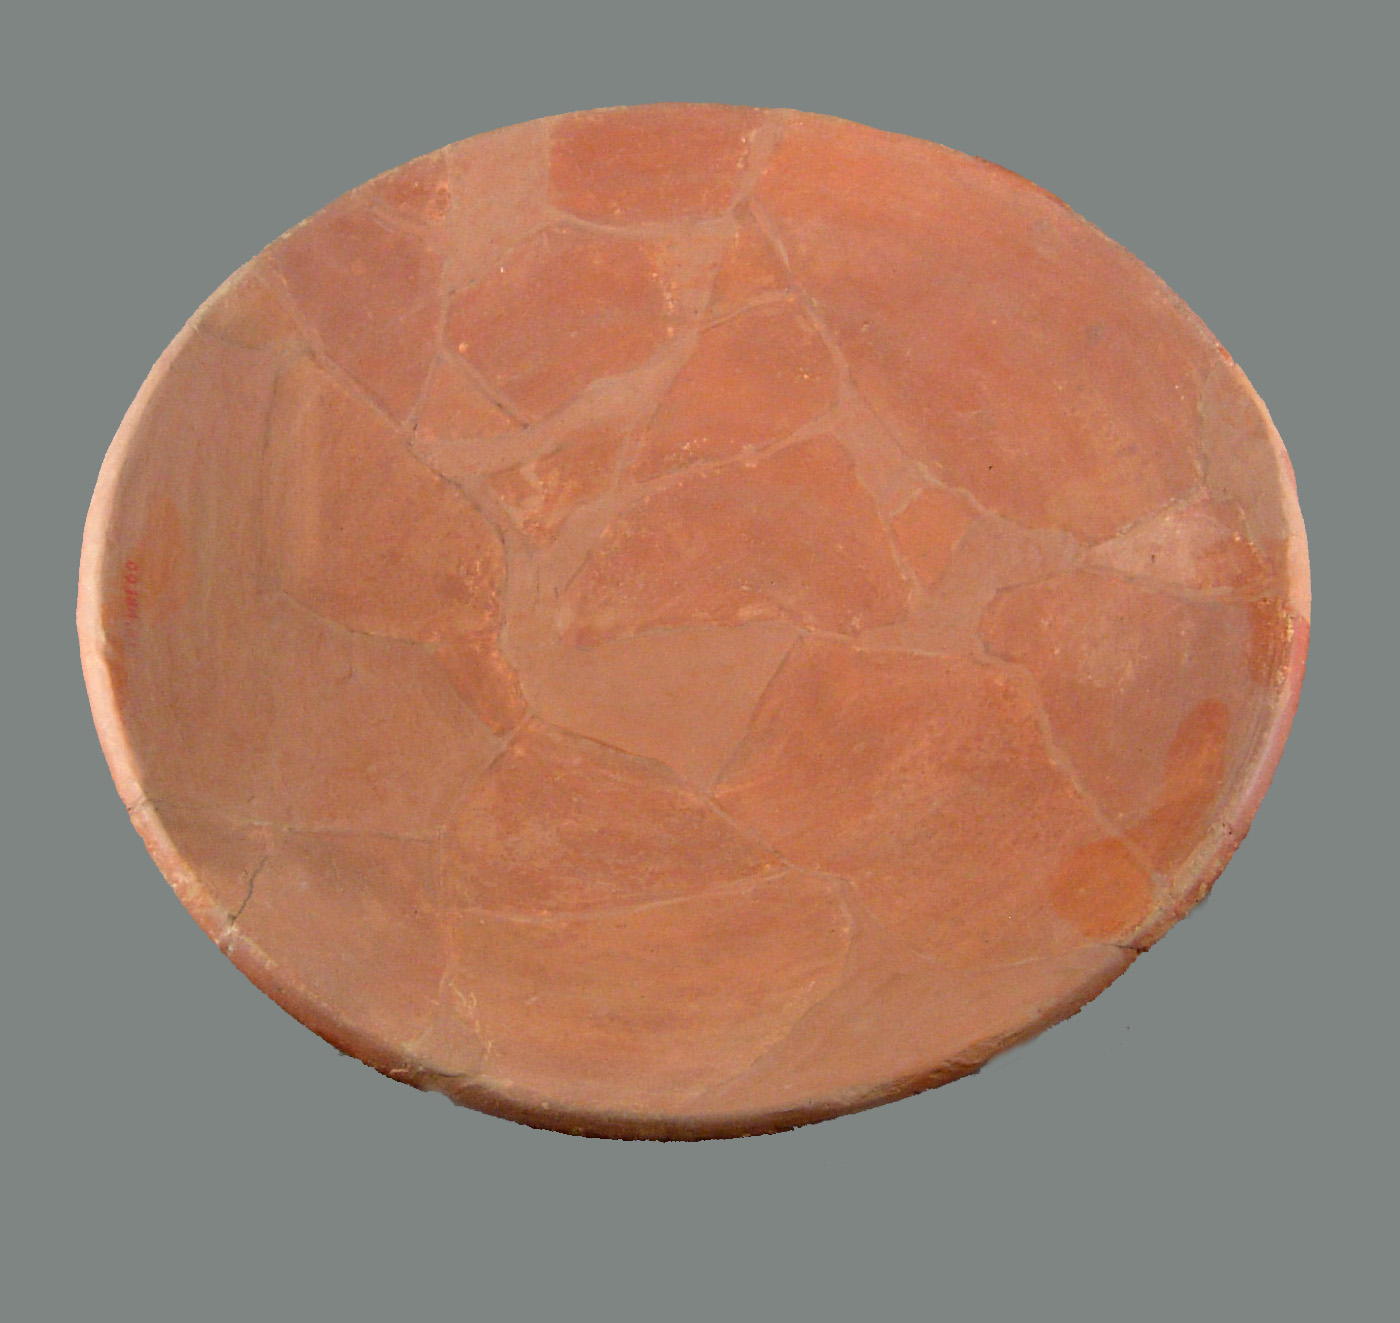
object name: fragment of a dish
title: Fragments of a Dish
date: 1336-1327 BCE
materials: mineral, pottery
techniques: wash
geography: egypt